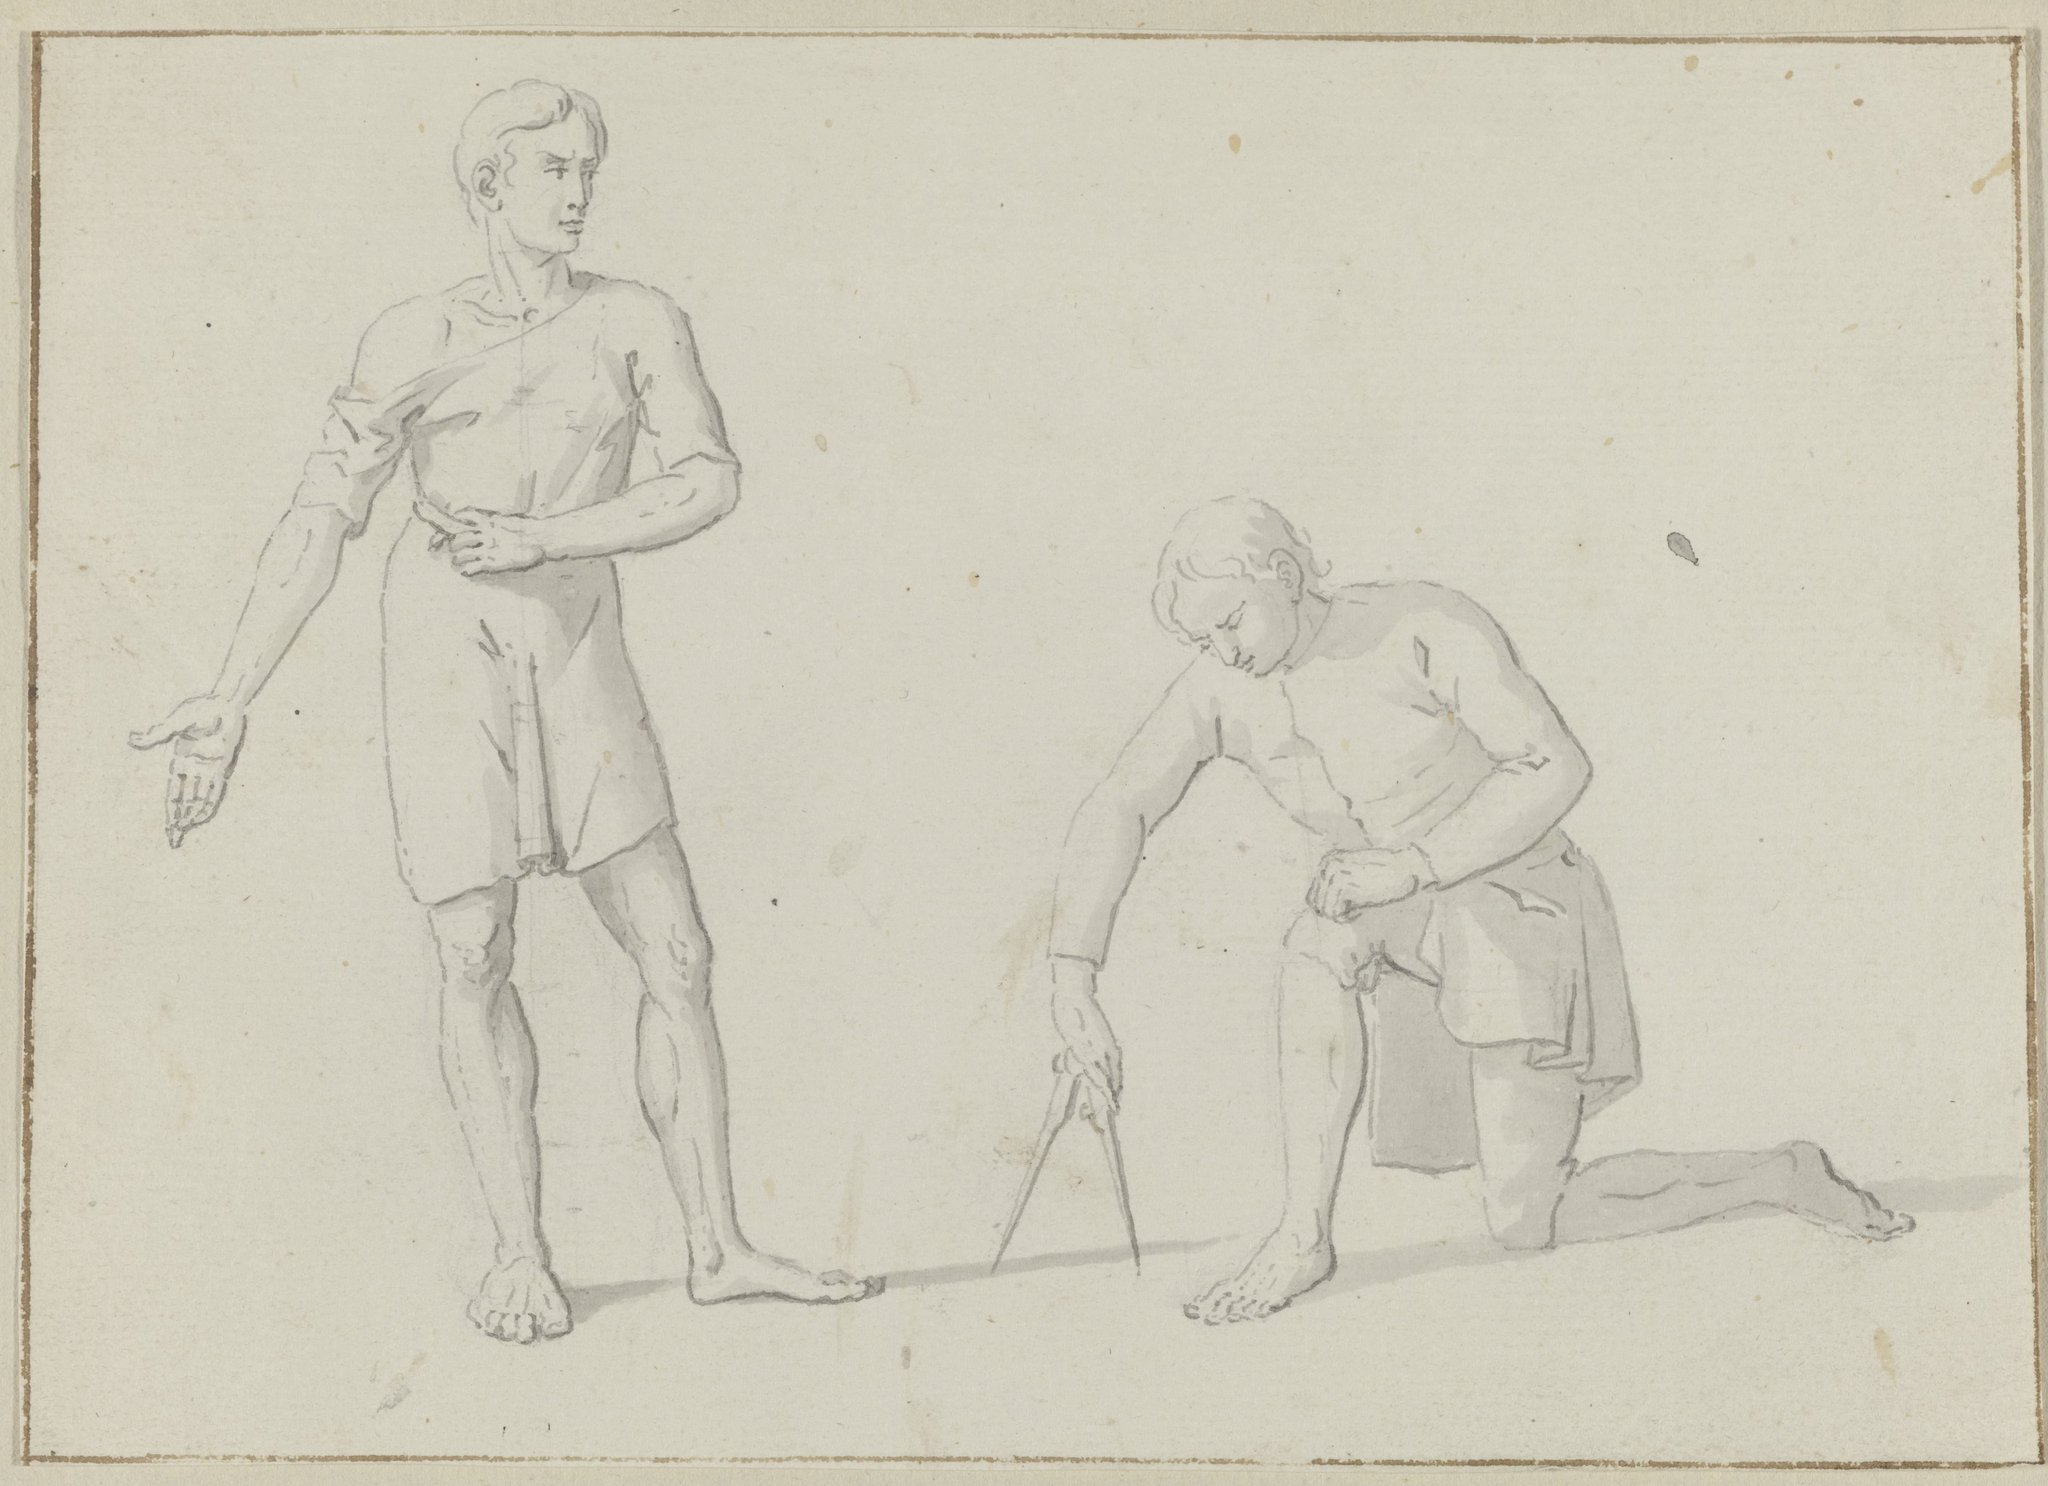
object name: drawing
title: Staande man en geknielde man met passer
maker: Anonymous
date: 1700-1799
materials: ink, paper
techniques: brush, pen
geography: netherlands